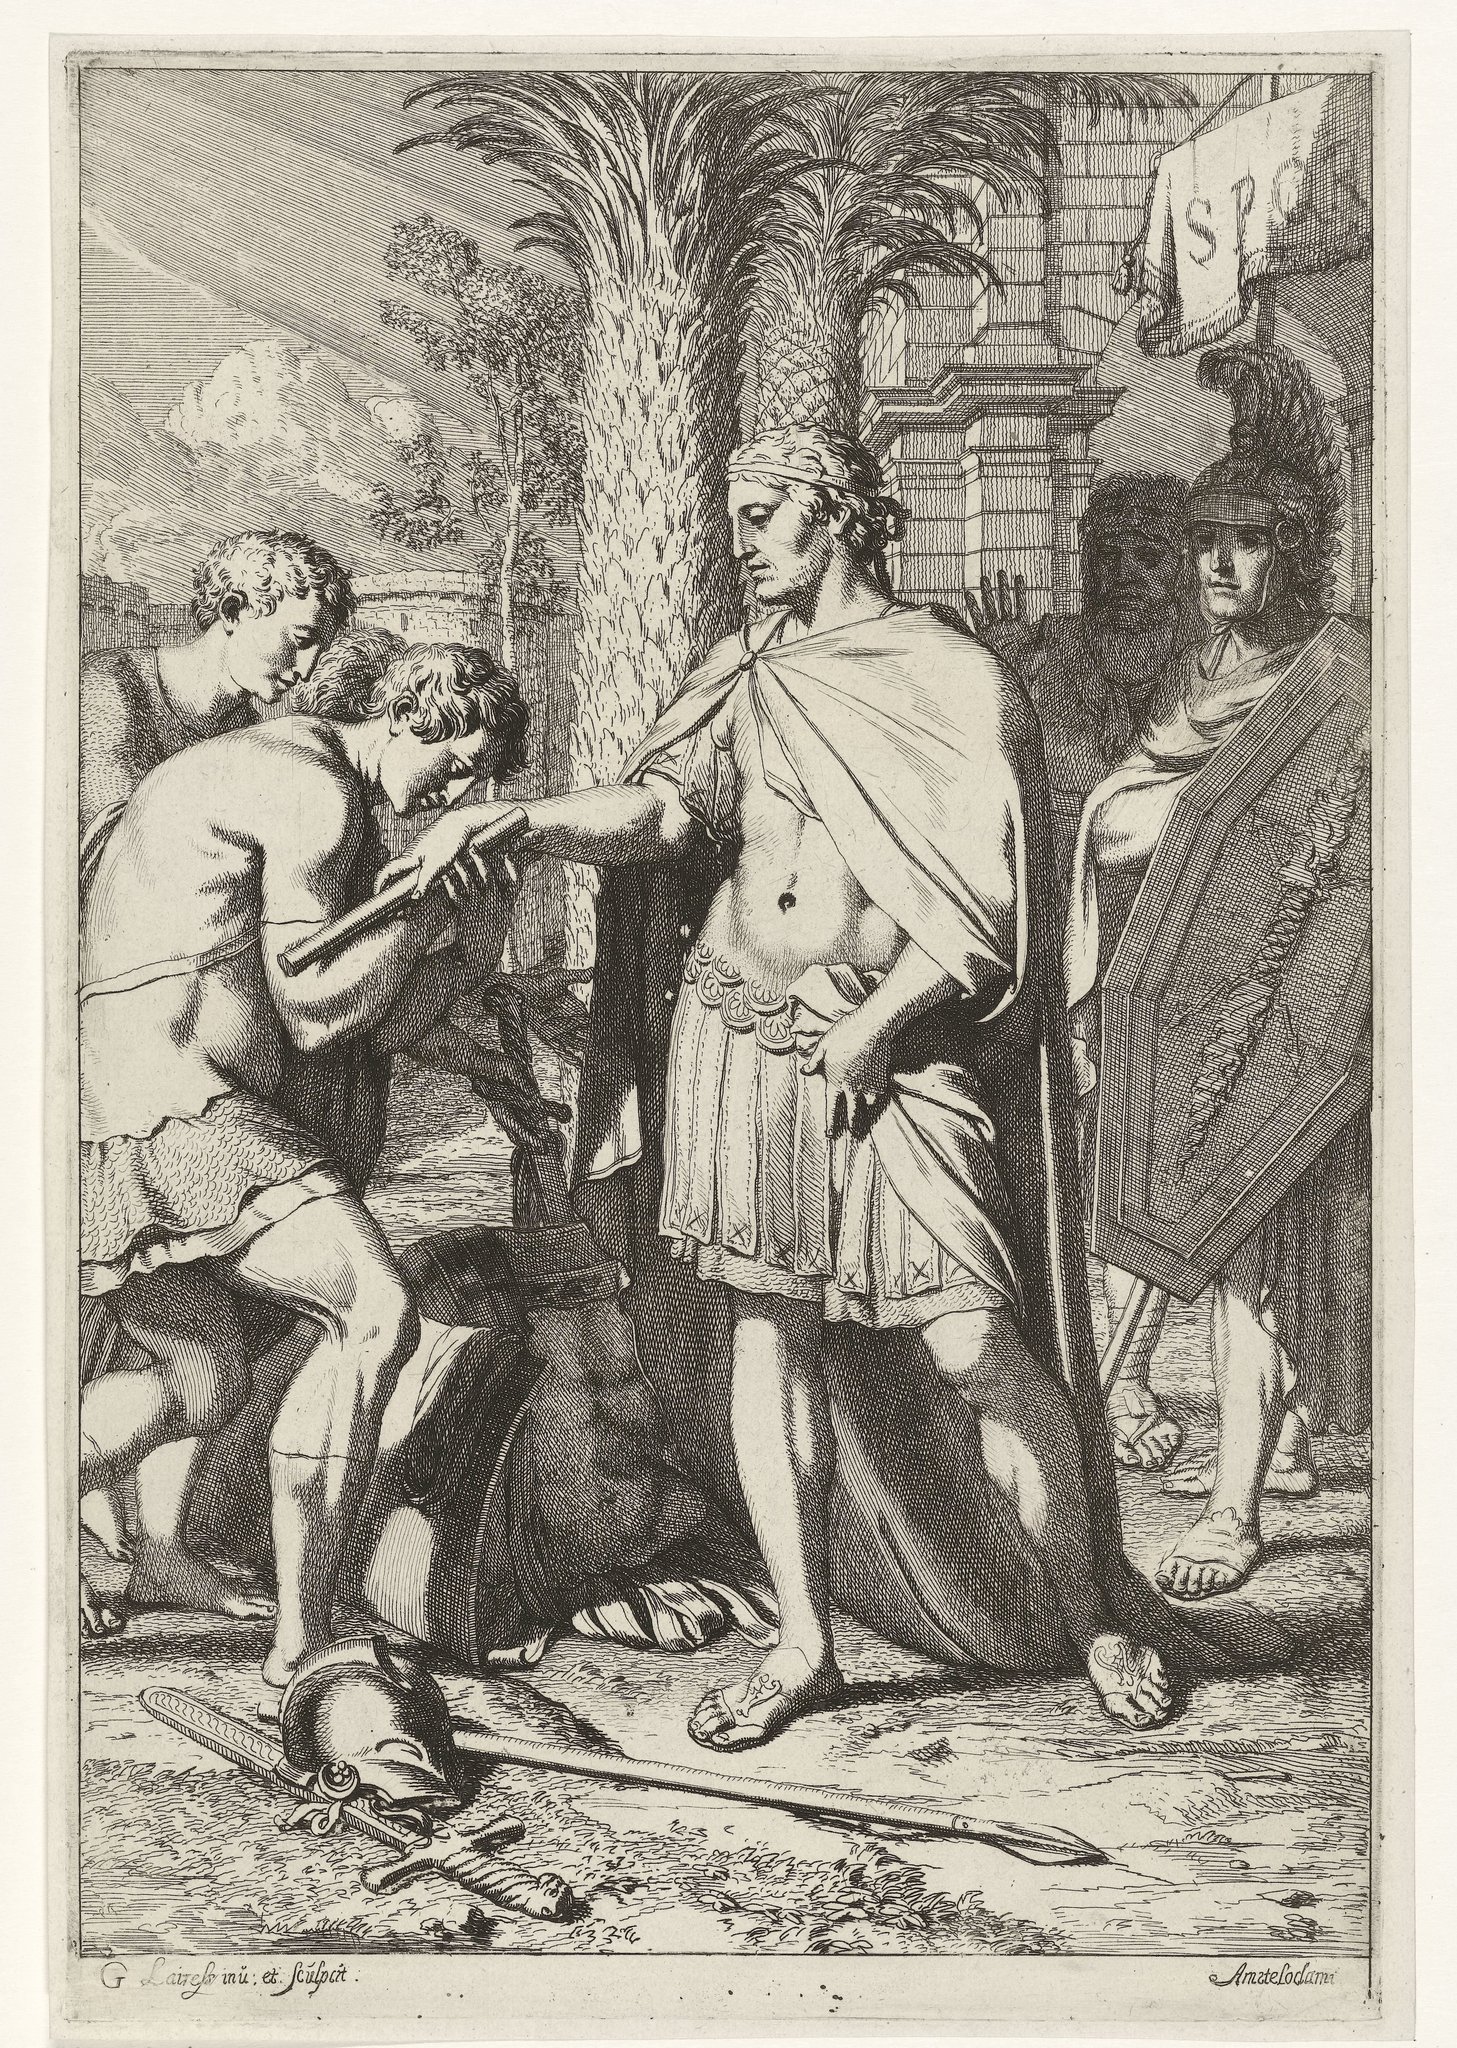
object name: print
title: Veldheer schenkt verslagen krijgslieden genade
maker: gerard de lairesse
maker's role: draughtsman, painter, print maker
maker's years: 1641-1711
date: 1670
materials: paper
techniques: etching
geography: amsterdam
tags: forgivingness (+ symbolical representation of concept), the defeated before the victor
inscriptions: collector's mark: Lugt 240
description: Twee verslagen krijgslieden ontvangen genade van een Romeins veldheer. Buigend kussen ze zijn hand waarin hij een scepter vasthoudt. Deze prent illustreert het eerste deel van het door Vergilius opgenomen grondbeginsel van de Romeinse politiek: "Parcere subiectis, sed debellare superbos" (Vergilius, Aeneïs 6.853). Volgens dit beginsel zouden de onderworpenen worden gespaard, maar zij die zich hardnekkig bleven verzetten werden vernietigd. Pendant van een prent over het tweede deel van deze stelregel.